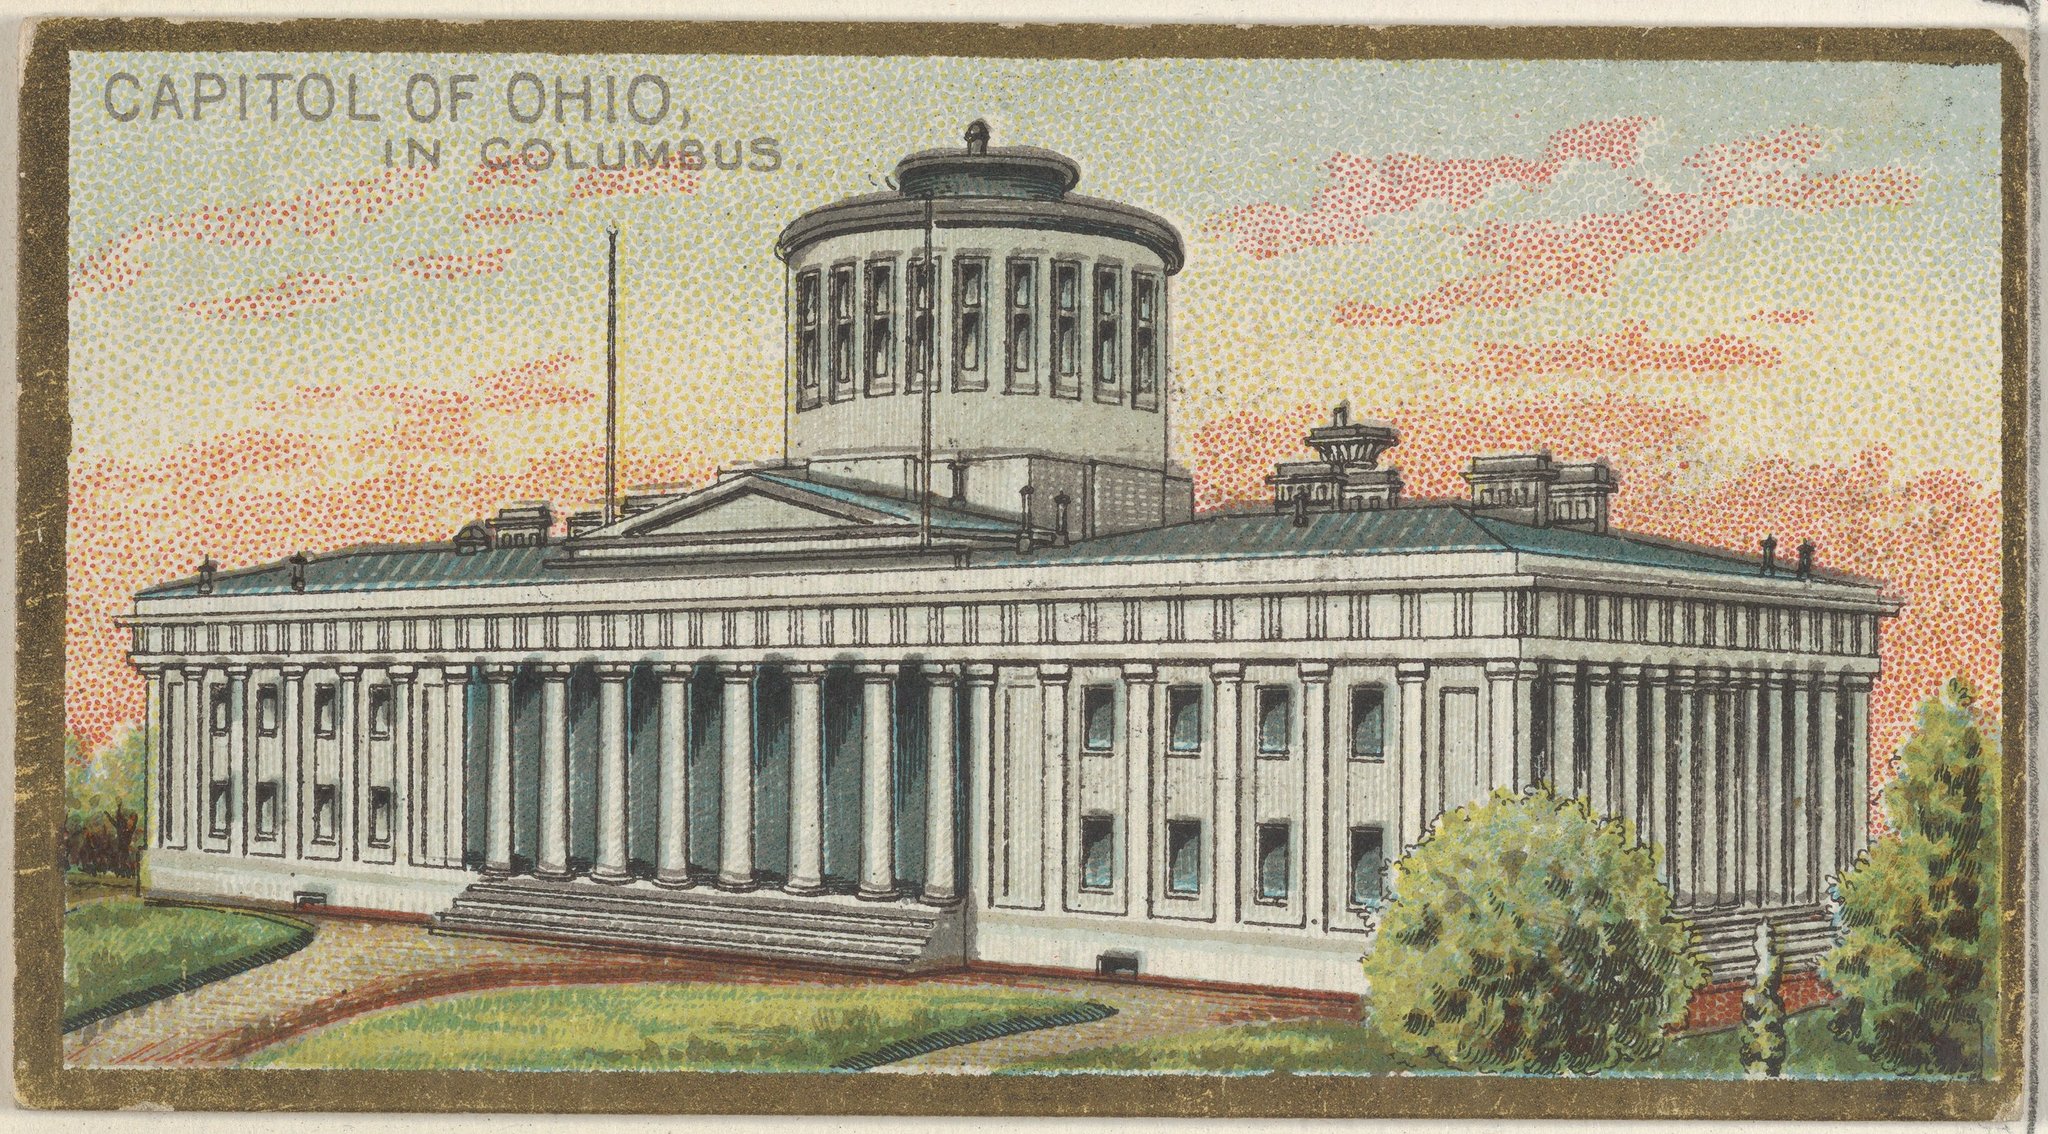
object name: print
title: Capitol of Ohio in Columbus, from the General Government and State Capitol Buildings series (N14) for Allen & Ginter Cigarettes Brands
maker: allen & ginter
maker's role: publisher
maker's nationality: american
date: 1889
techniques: color lithograph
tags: buildings